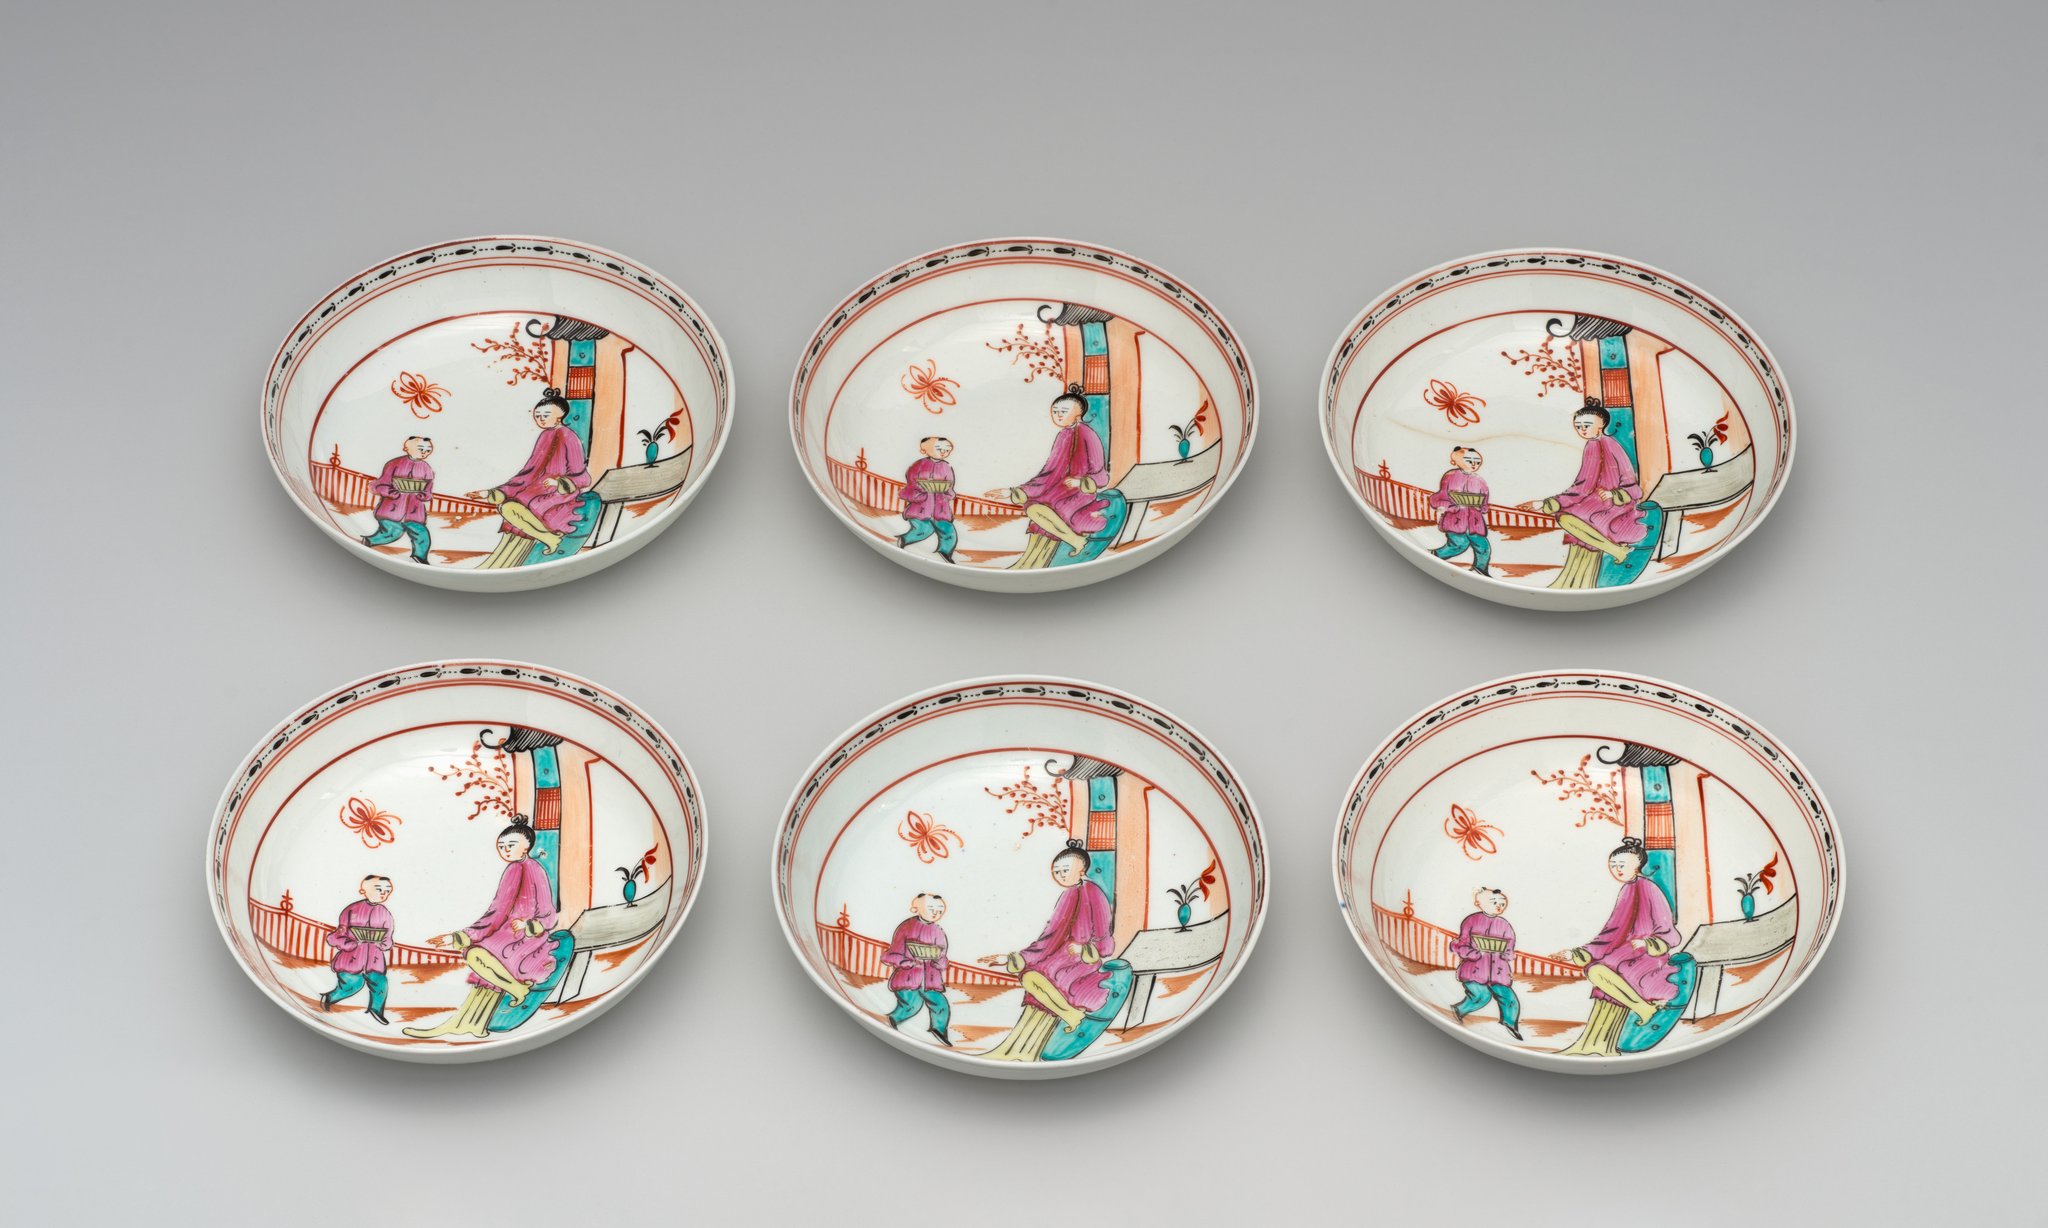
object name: saucer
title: Six saucers (part of a service)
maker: lowestoft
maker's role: factory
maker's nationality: british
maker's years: 1757-1803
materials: soft paste porcelain